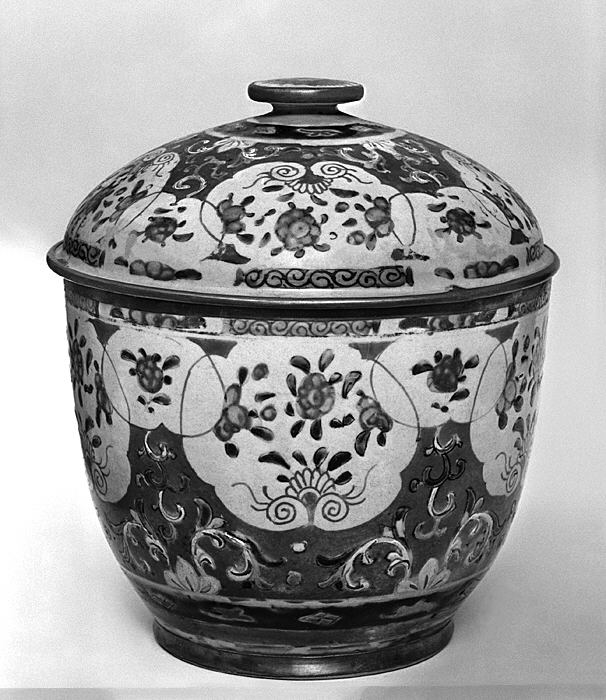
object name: covered bowl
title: Covered bowl with floral pattern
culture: chinese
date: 1801-1900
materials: enamel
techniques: overglaze, painting, polychrome